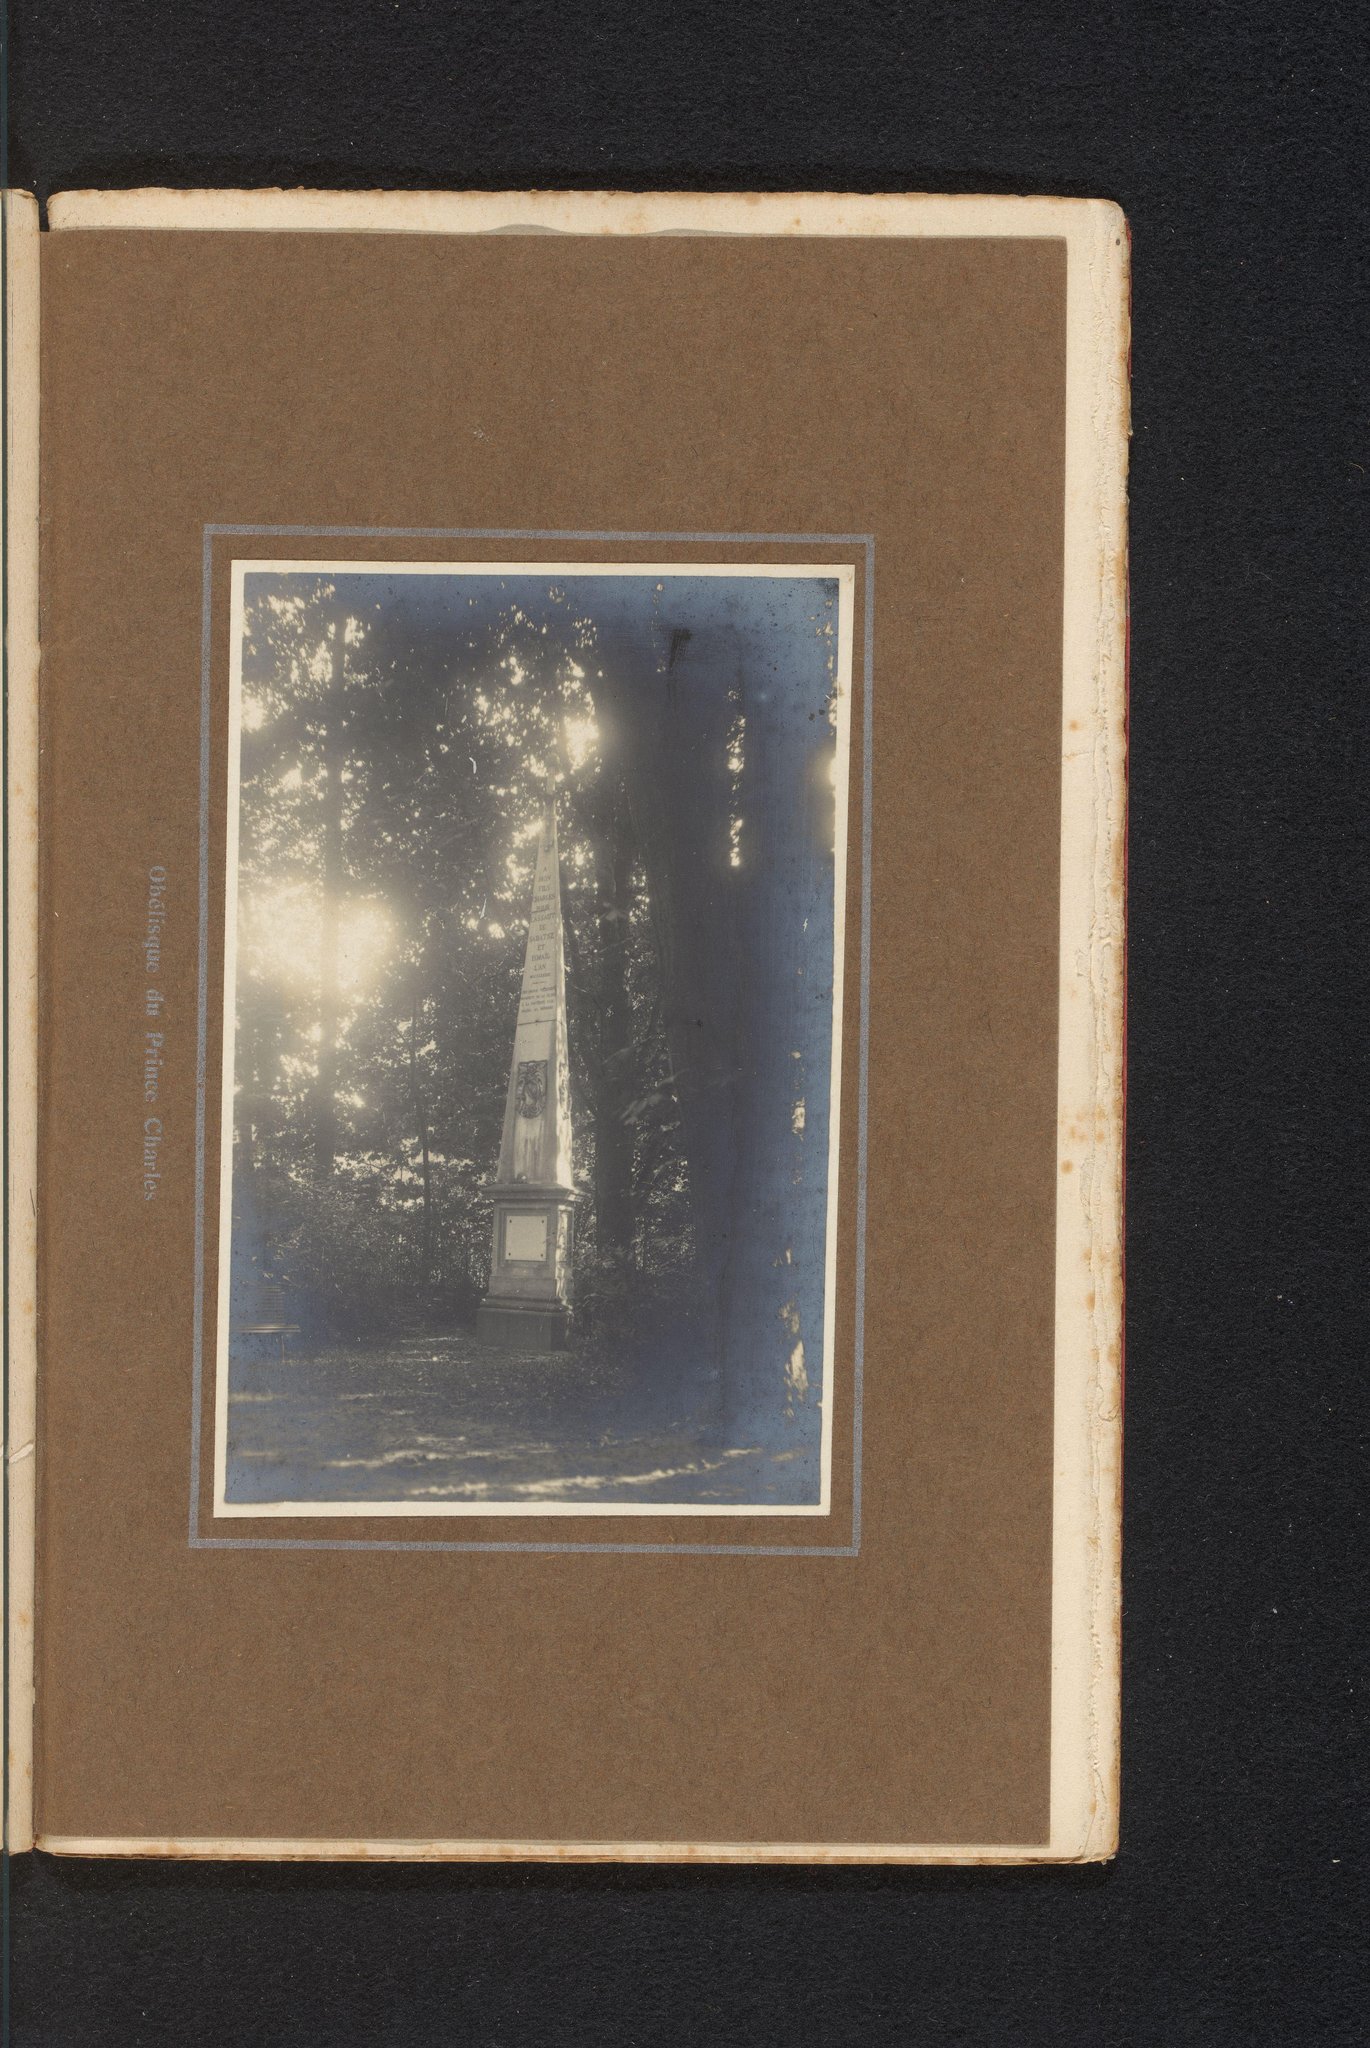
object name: photograph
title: Obélisque du Prince Charles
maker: coppin-goisse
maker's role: printer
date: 1904-1909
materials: photographic support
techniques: gelatin silver print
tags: trees, obelisk, needle